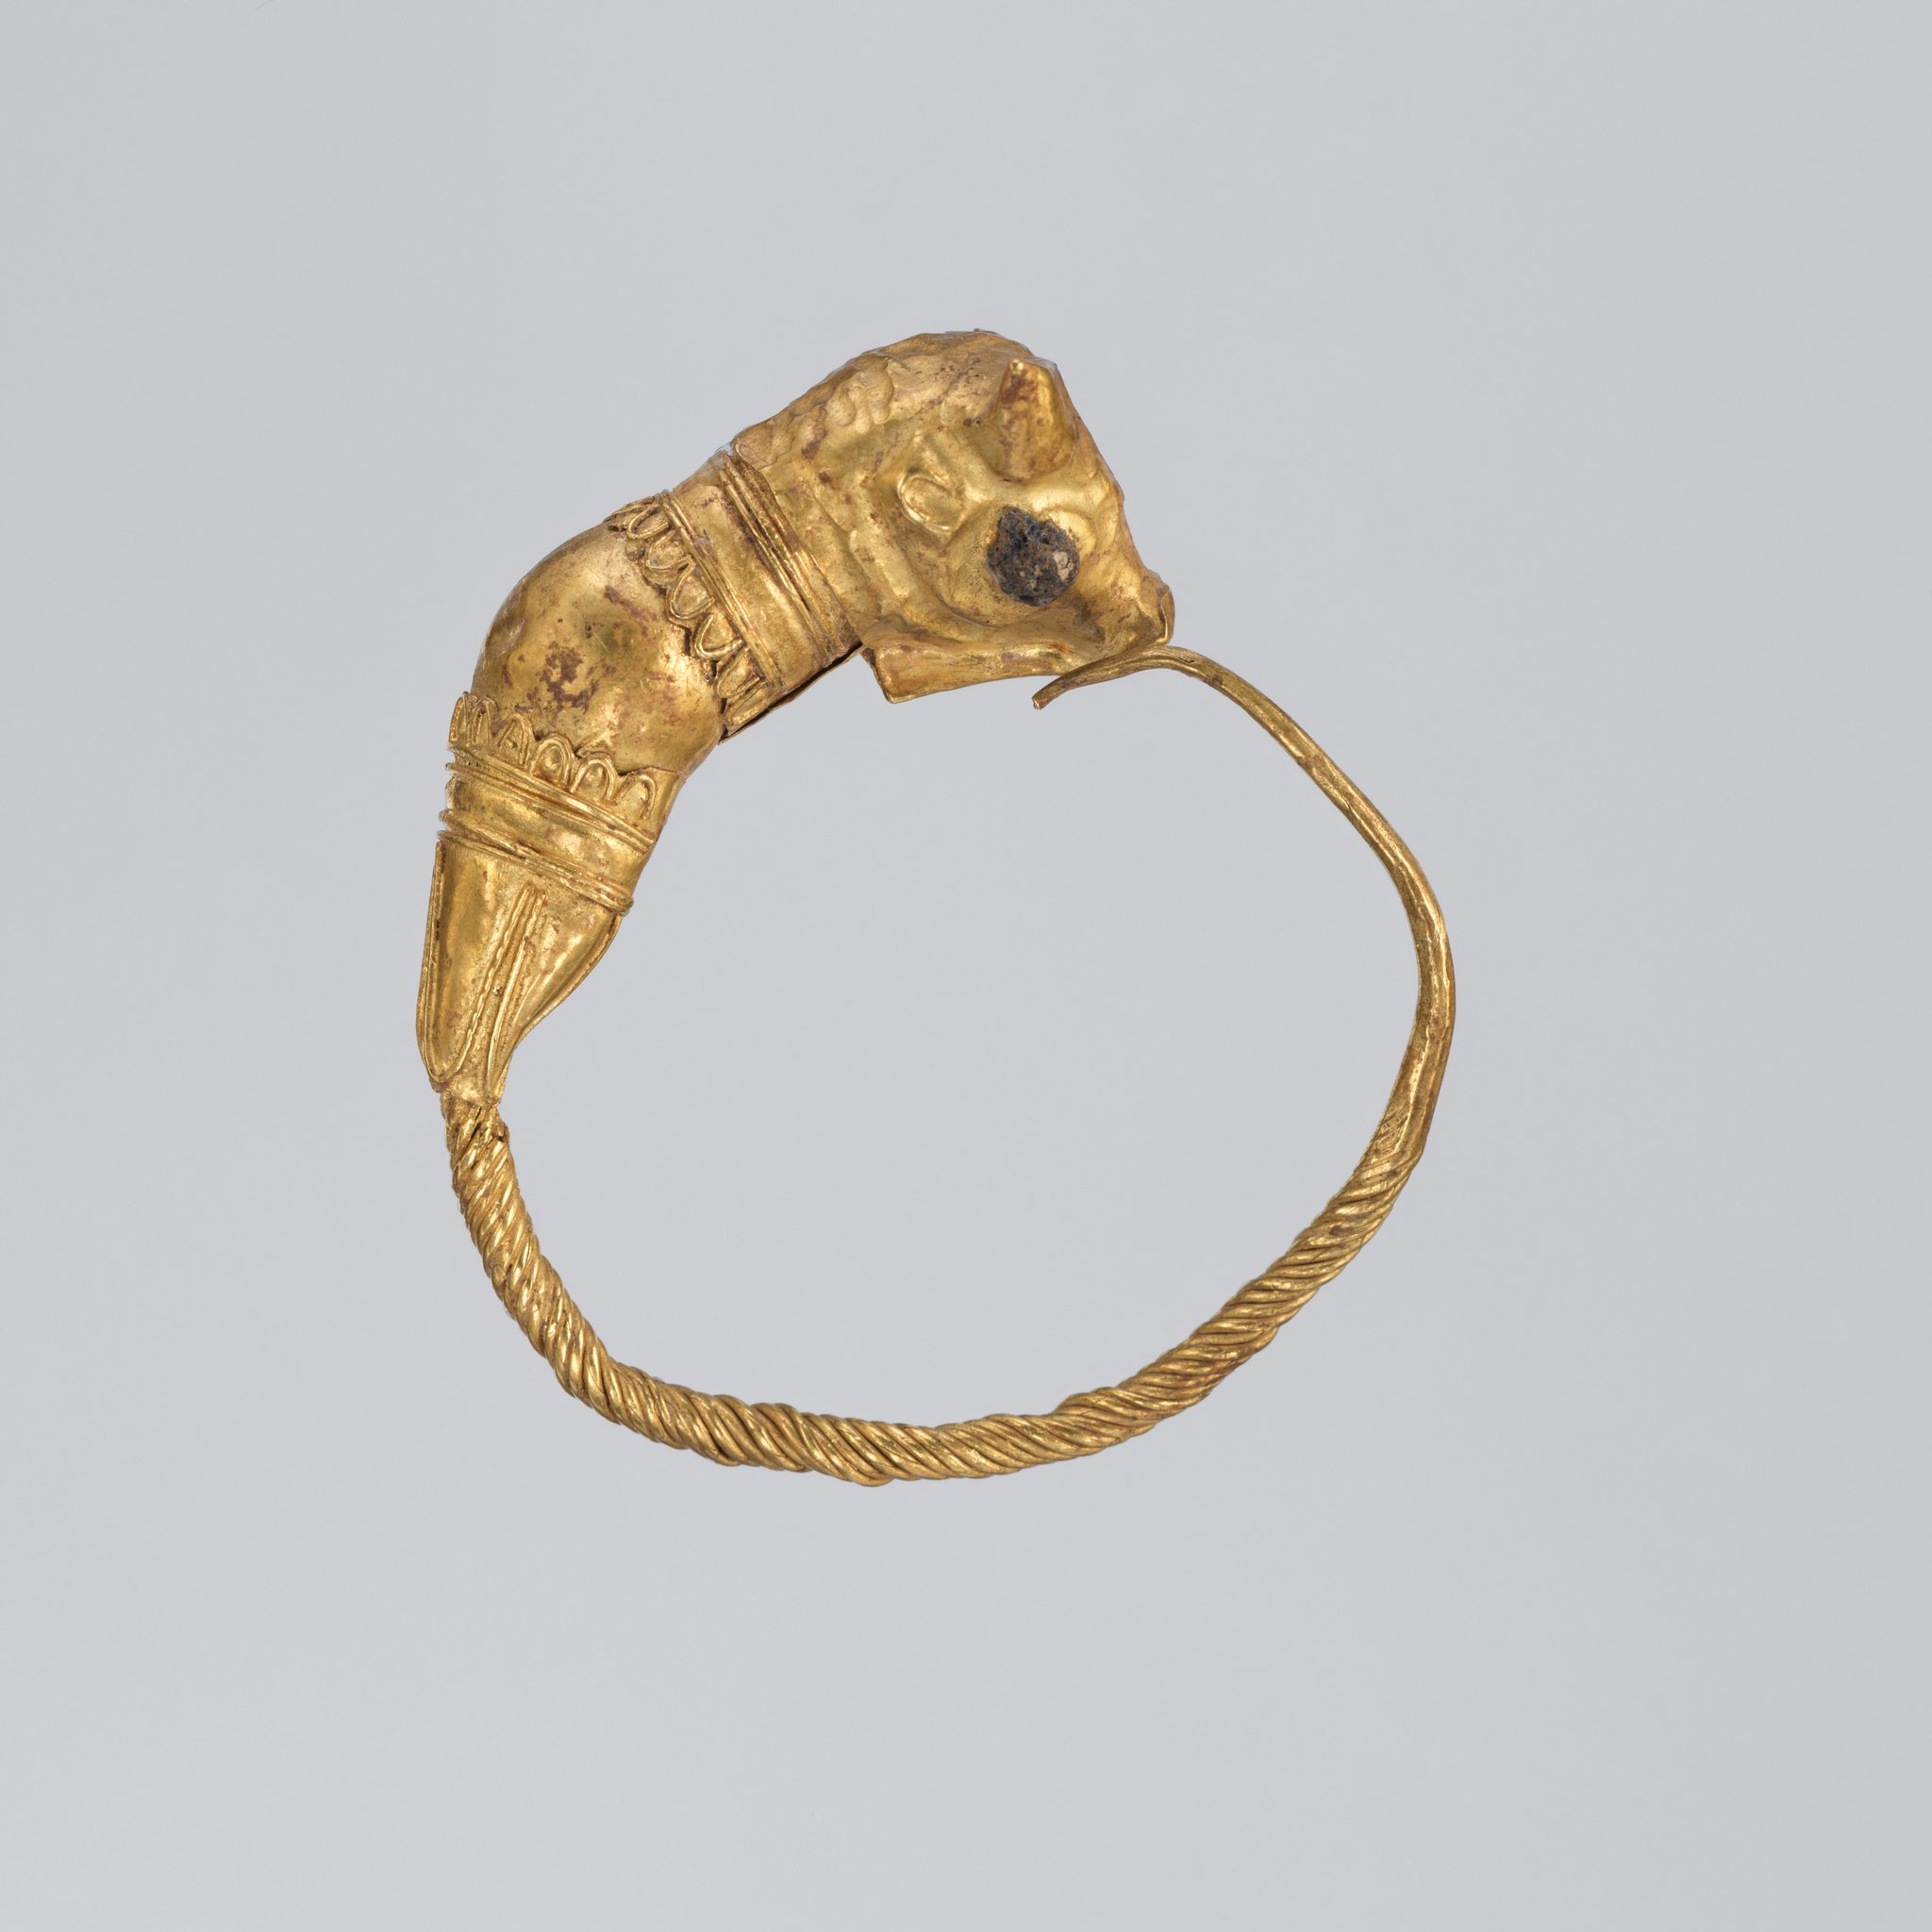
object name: earring with head of bull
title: Gold earring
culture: cypriot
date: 334-201 BCE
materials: gold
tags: bulls